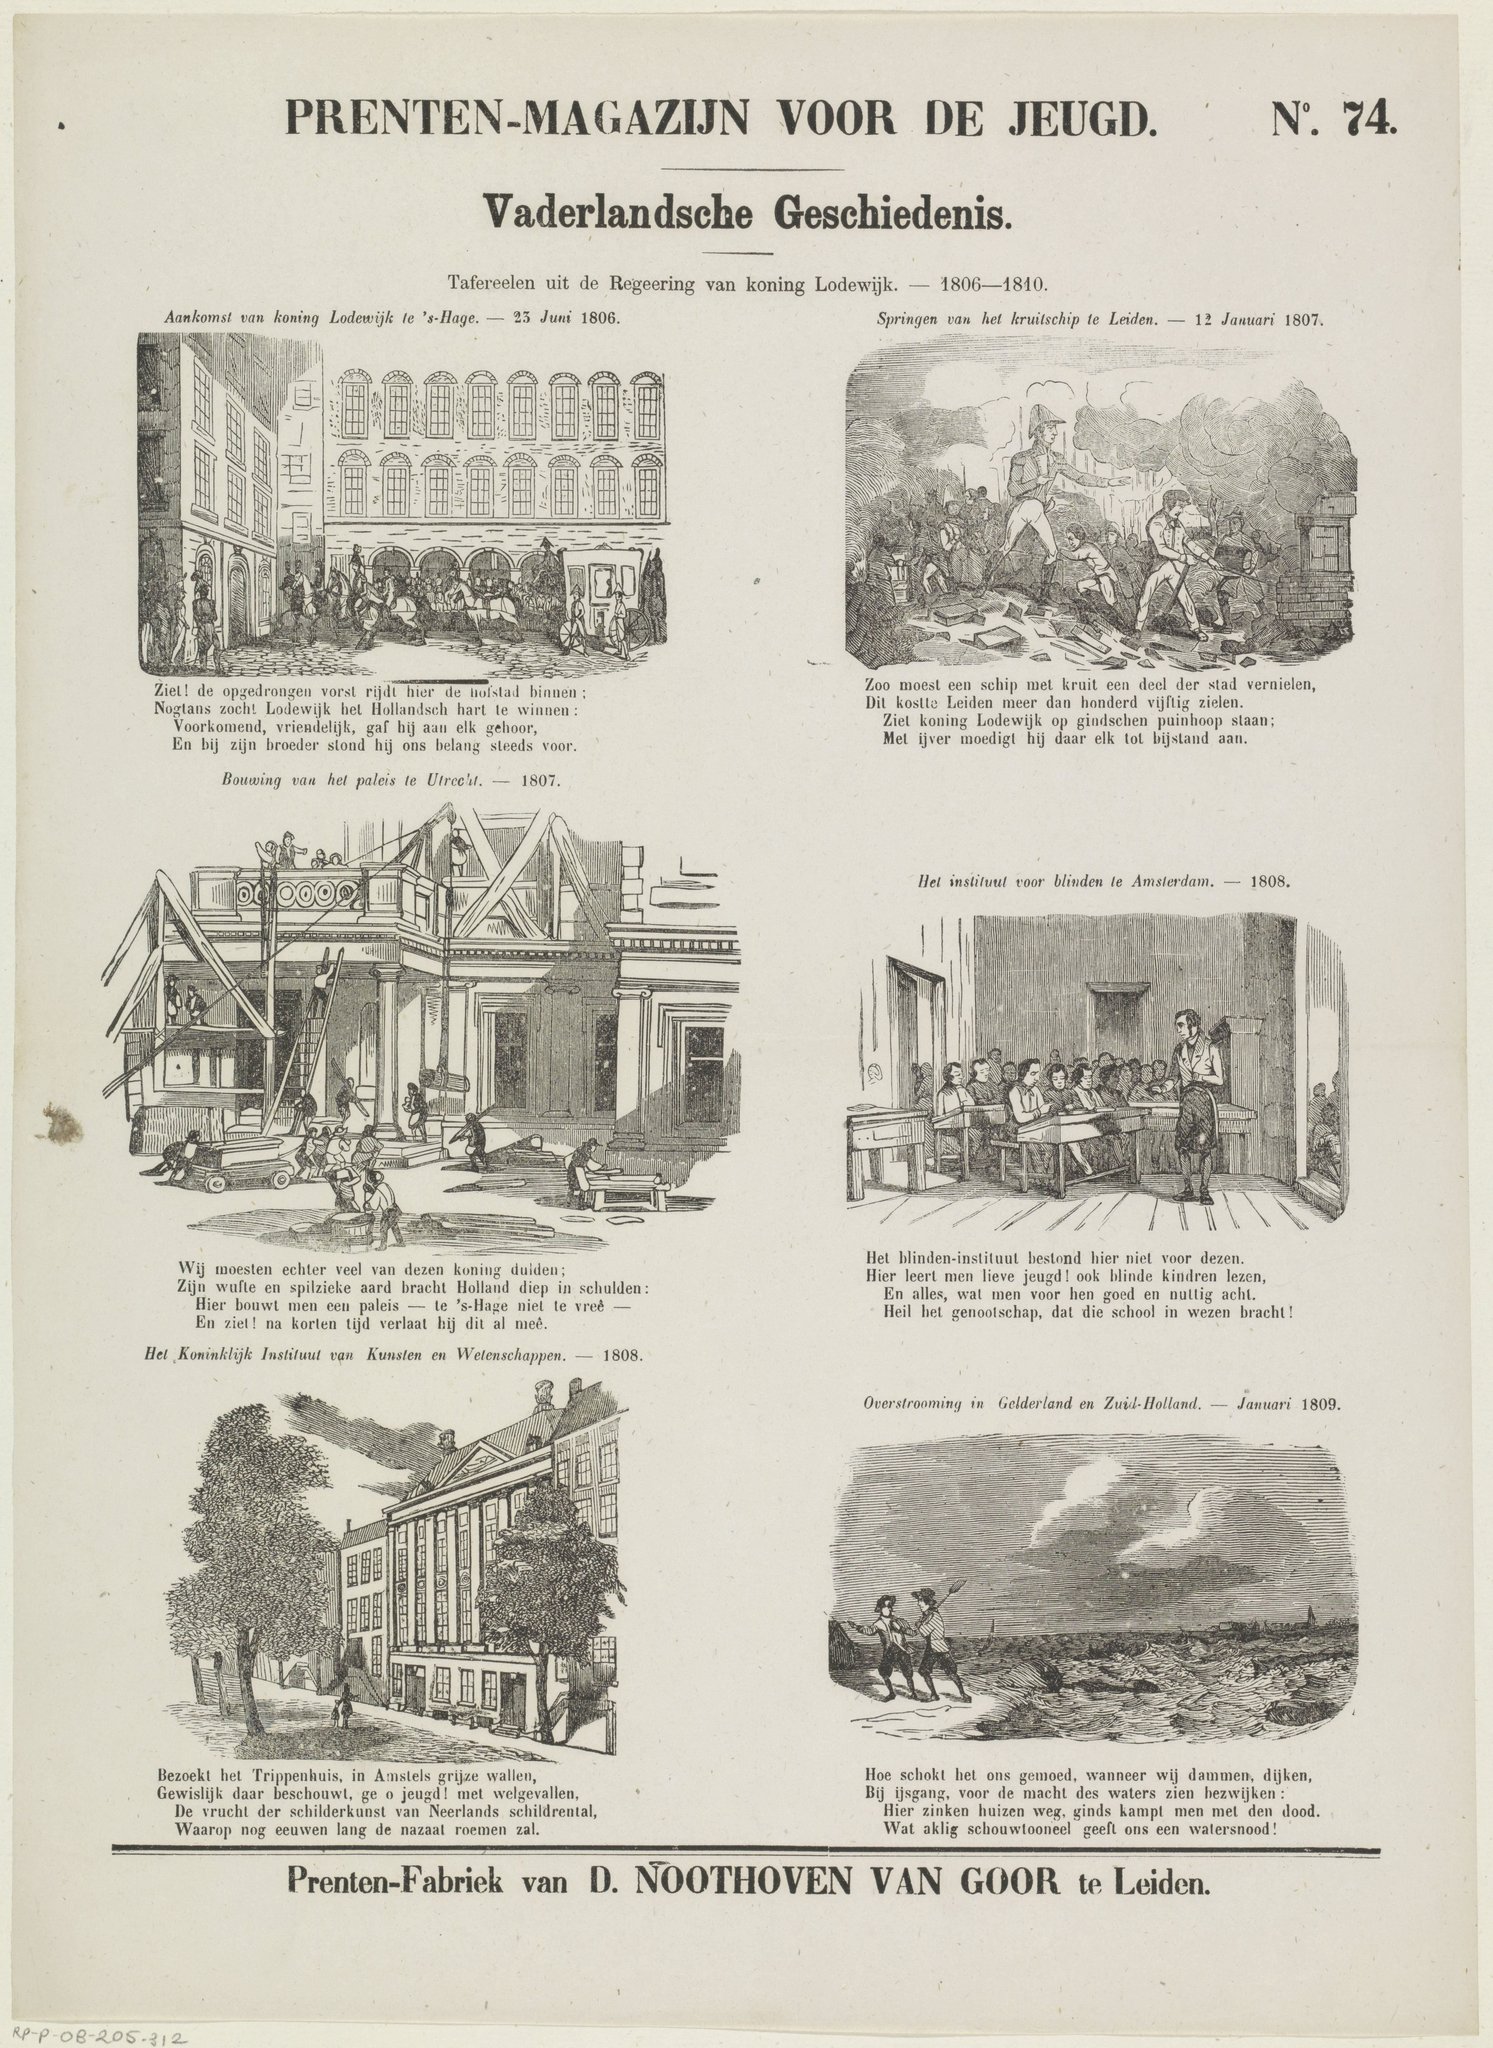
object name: print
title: Vaderlandsche geschiedenis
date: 1850-1881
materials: paper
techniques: letterpress printing, engraving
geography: leiden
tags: louis napoleon (king of holland), history, leiden, the hague, utrecht, amsterdam, gelderland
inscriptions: collector's mark: Lugt 2760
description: Blad met 6 voorstellingen van gebeurtenissen ten tijde van de regering van Lodewijk Napoleon tussen 1806 en 1810. Boven elke voorstelling een titel en onder elke voorstelling een vierregelig vers. Genummerd rechtsboven: No. 74.